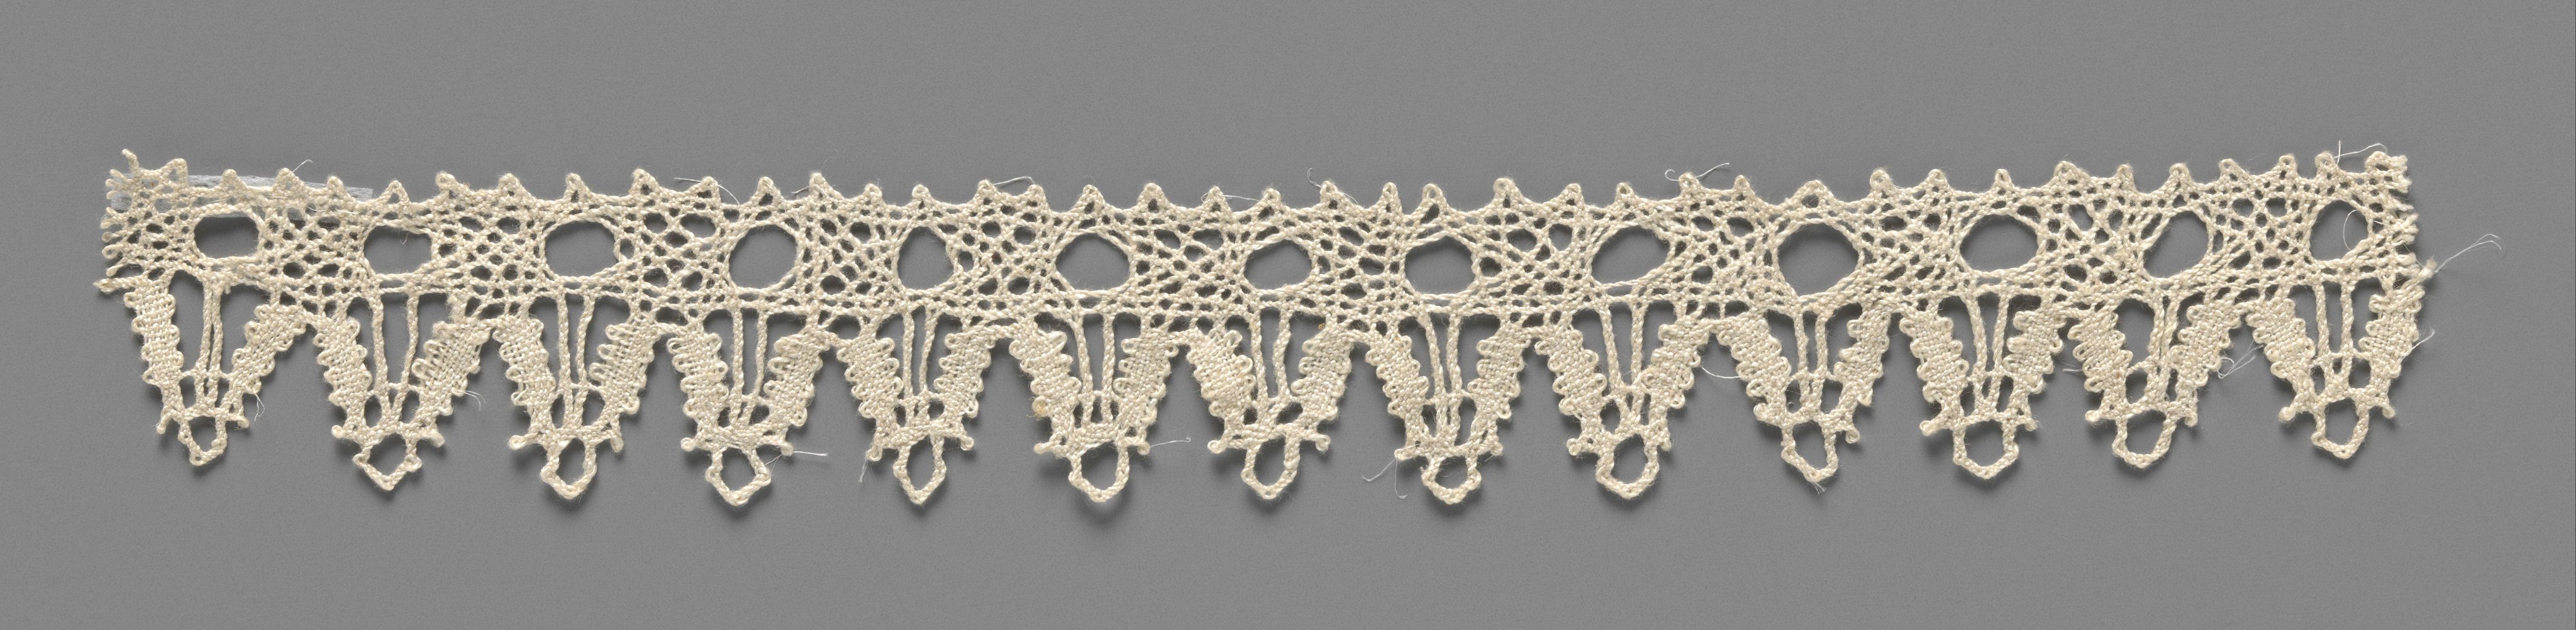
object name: strip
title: Strook kloskant met driehoekige schulpen waaronder een gevlochten cirkeltje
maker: Anonymous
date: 1925-1937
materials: linen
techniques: lace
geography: pescocostanzo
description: Strook naturelkleurige kloskant. Het zich herhalende en symmetrische patroon bestaat uit een band met opengewerkte cirkels in een traliegrond. Onder de band hangen driehoekige schulpen, steeds één schulp onder één opengewerkte cirkel. In de driehoek lopen twee vlechtjes vanuit de band recht naar beneden. Onder elke driehoekige schulp hangt een cirkeltje gemaakt met een vlechtje. Het betreft 20e-eeuws kant gemaakt naar een 16e-eeuws patroon.